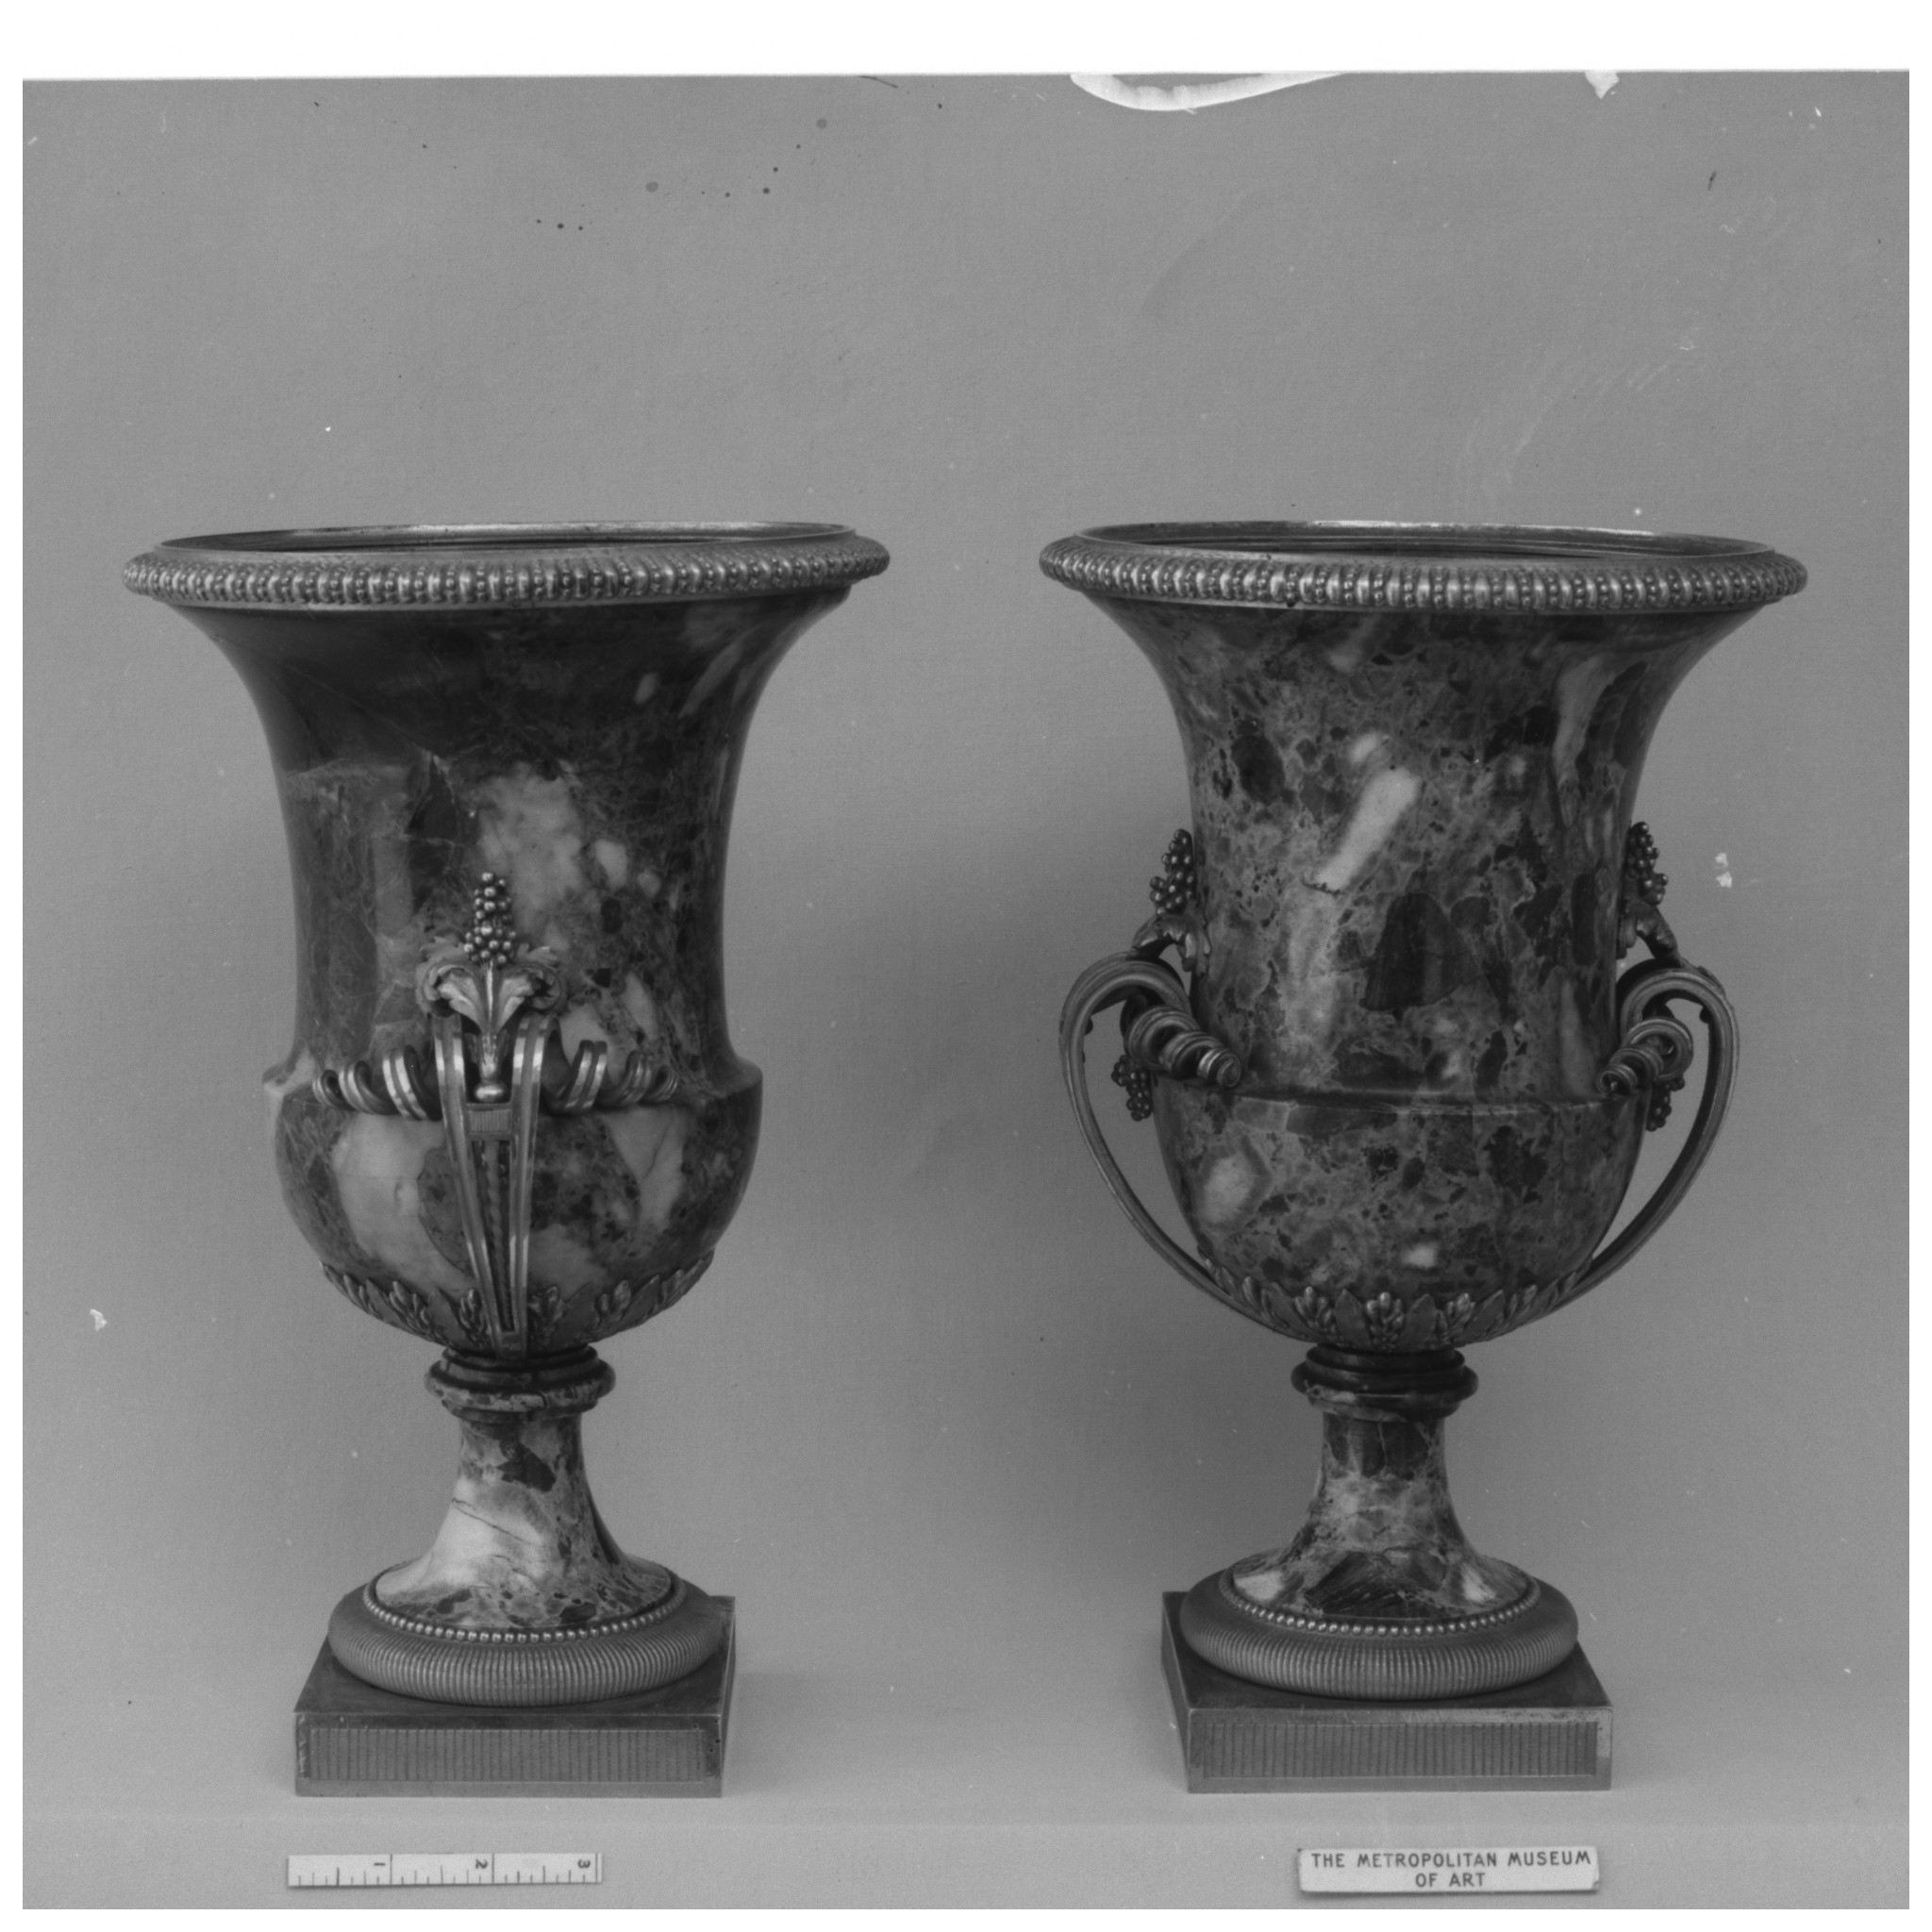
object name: vase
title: Vase (one of a pair)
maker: pierre gouthière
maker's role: maker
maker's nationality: french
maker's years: 1732-1814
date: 1701-1800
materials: gilt bronze, marble